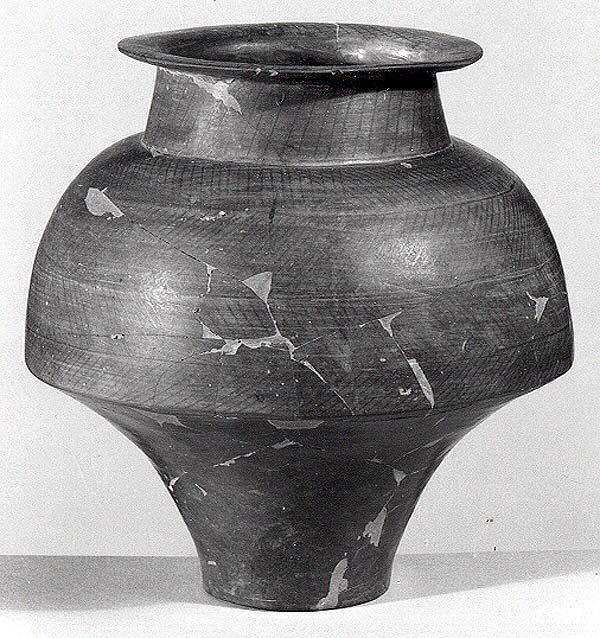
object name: vase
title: Carinated vase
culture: iranian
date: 3000-2250 BCE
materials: ceramic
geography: iran